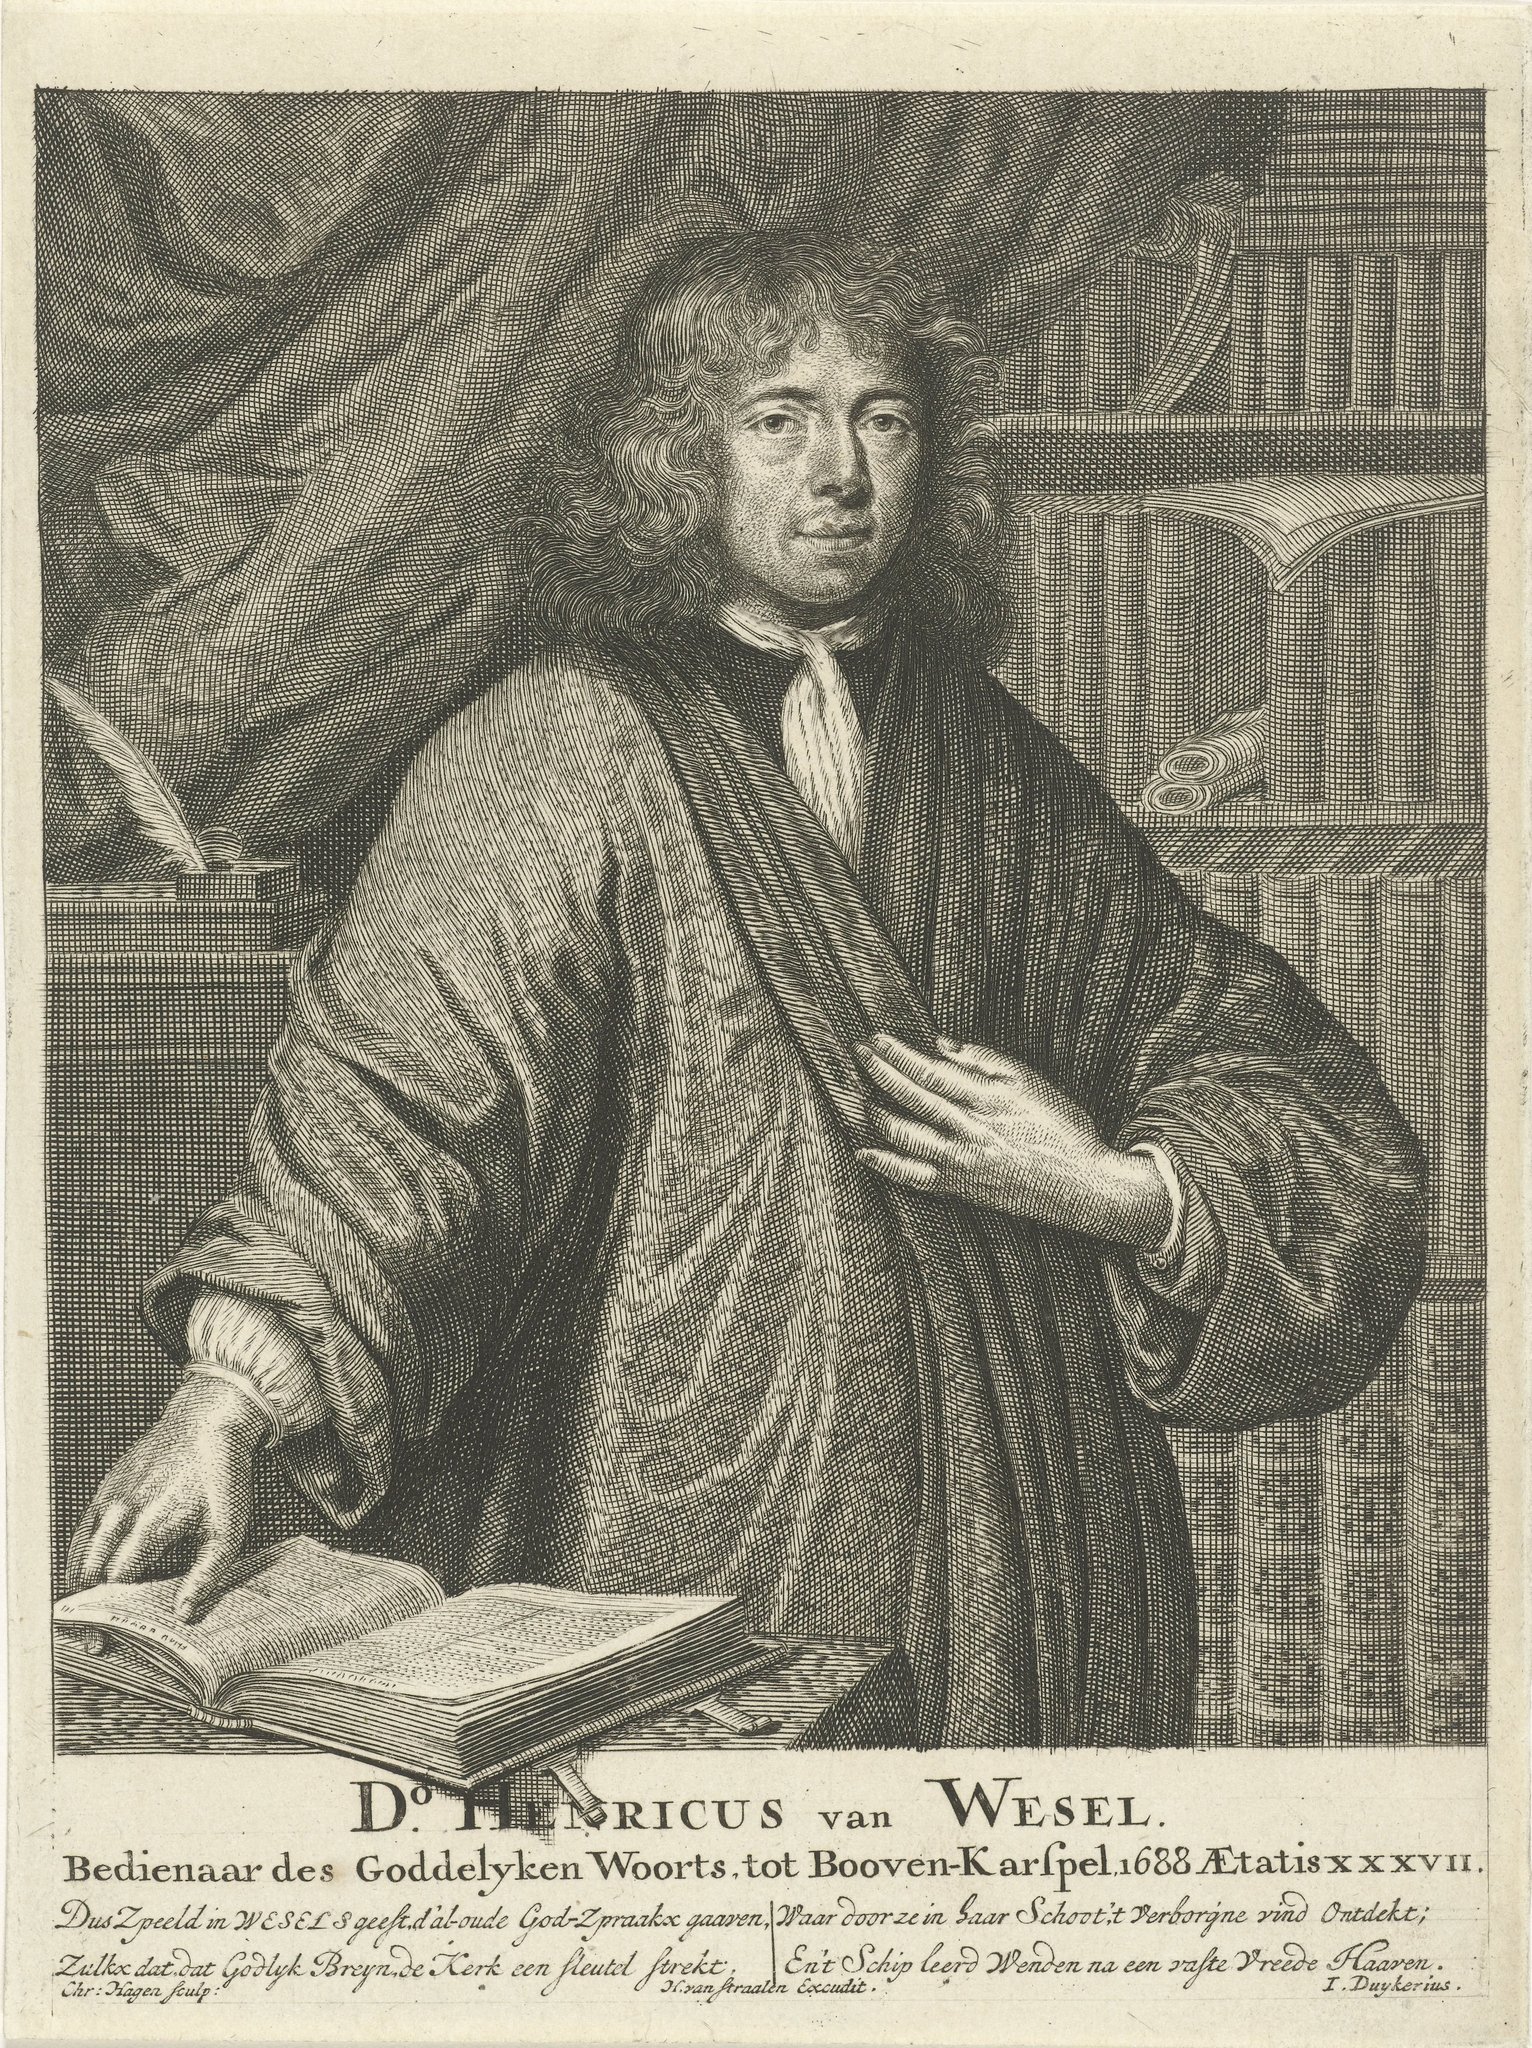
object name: print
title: Portret van Henricus van Wesel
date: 1688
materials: paper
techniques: engraving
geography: enkhuizen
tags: theologian, ink-well, writing tools, book - mm - book open, study; 'studiolo'; library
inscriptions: collector's mark: Lugt 2228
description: Kniestuk van Henricus van Wesel op 37-jarige leeftijd, staand voor een boekenkast, zijn rechthand op een opengeslagen boek op een tafel voor hem. Op de achtergrond een inktpot met een ganzenveer. Onder zijn portret zijn naam en een vierregelig vers in het Nederlands.